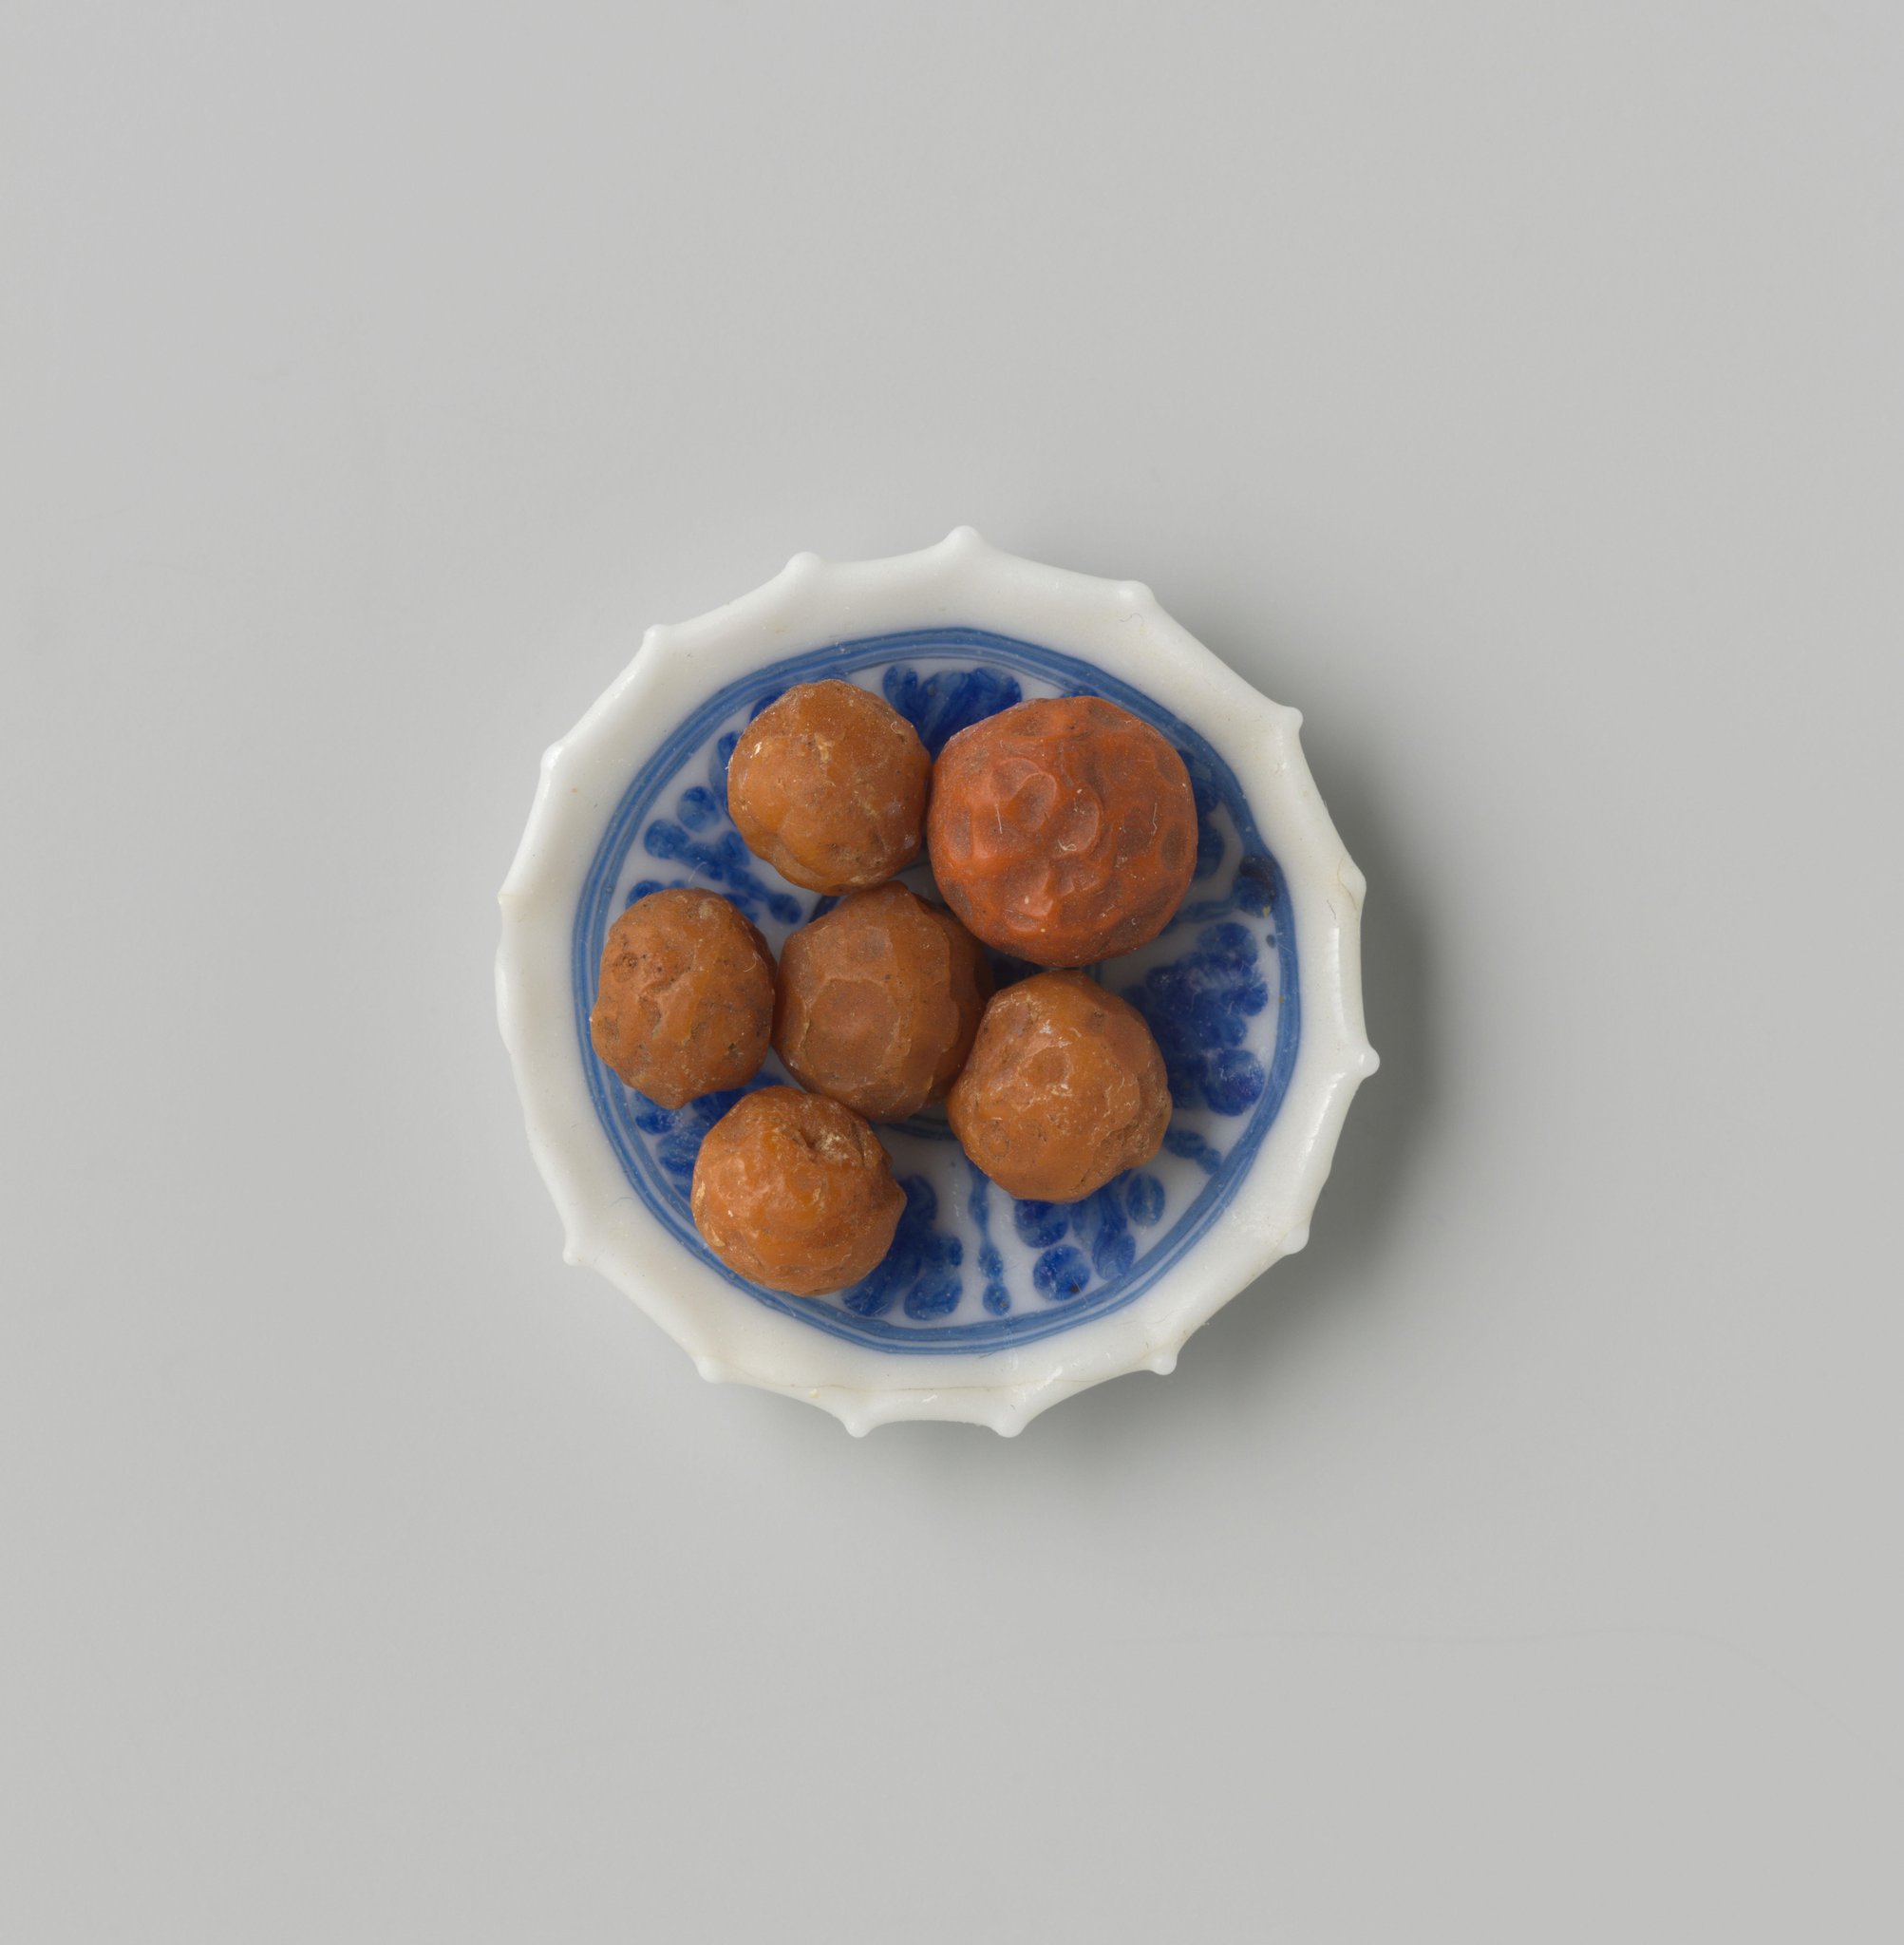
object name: miniature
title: Schotel van melkglas met blauwe emailverf beschildering, imitatie Chinees porselein; bloemmotieven in vakken in Kraakporselein stijl; dubbelwandig met in punten geknepen rand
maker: Anonymous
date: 1675-1710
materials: glass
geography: amsterdam